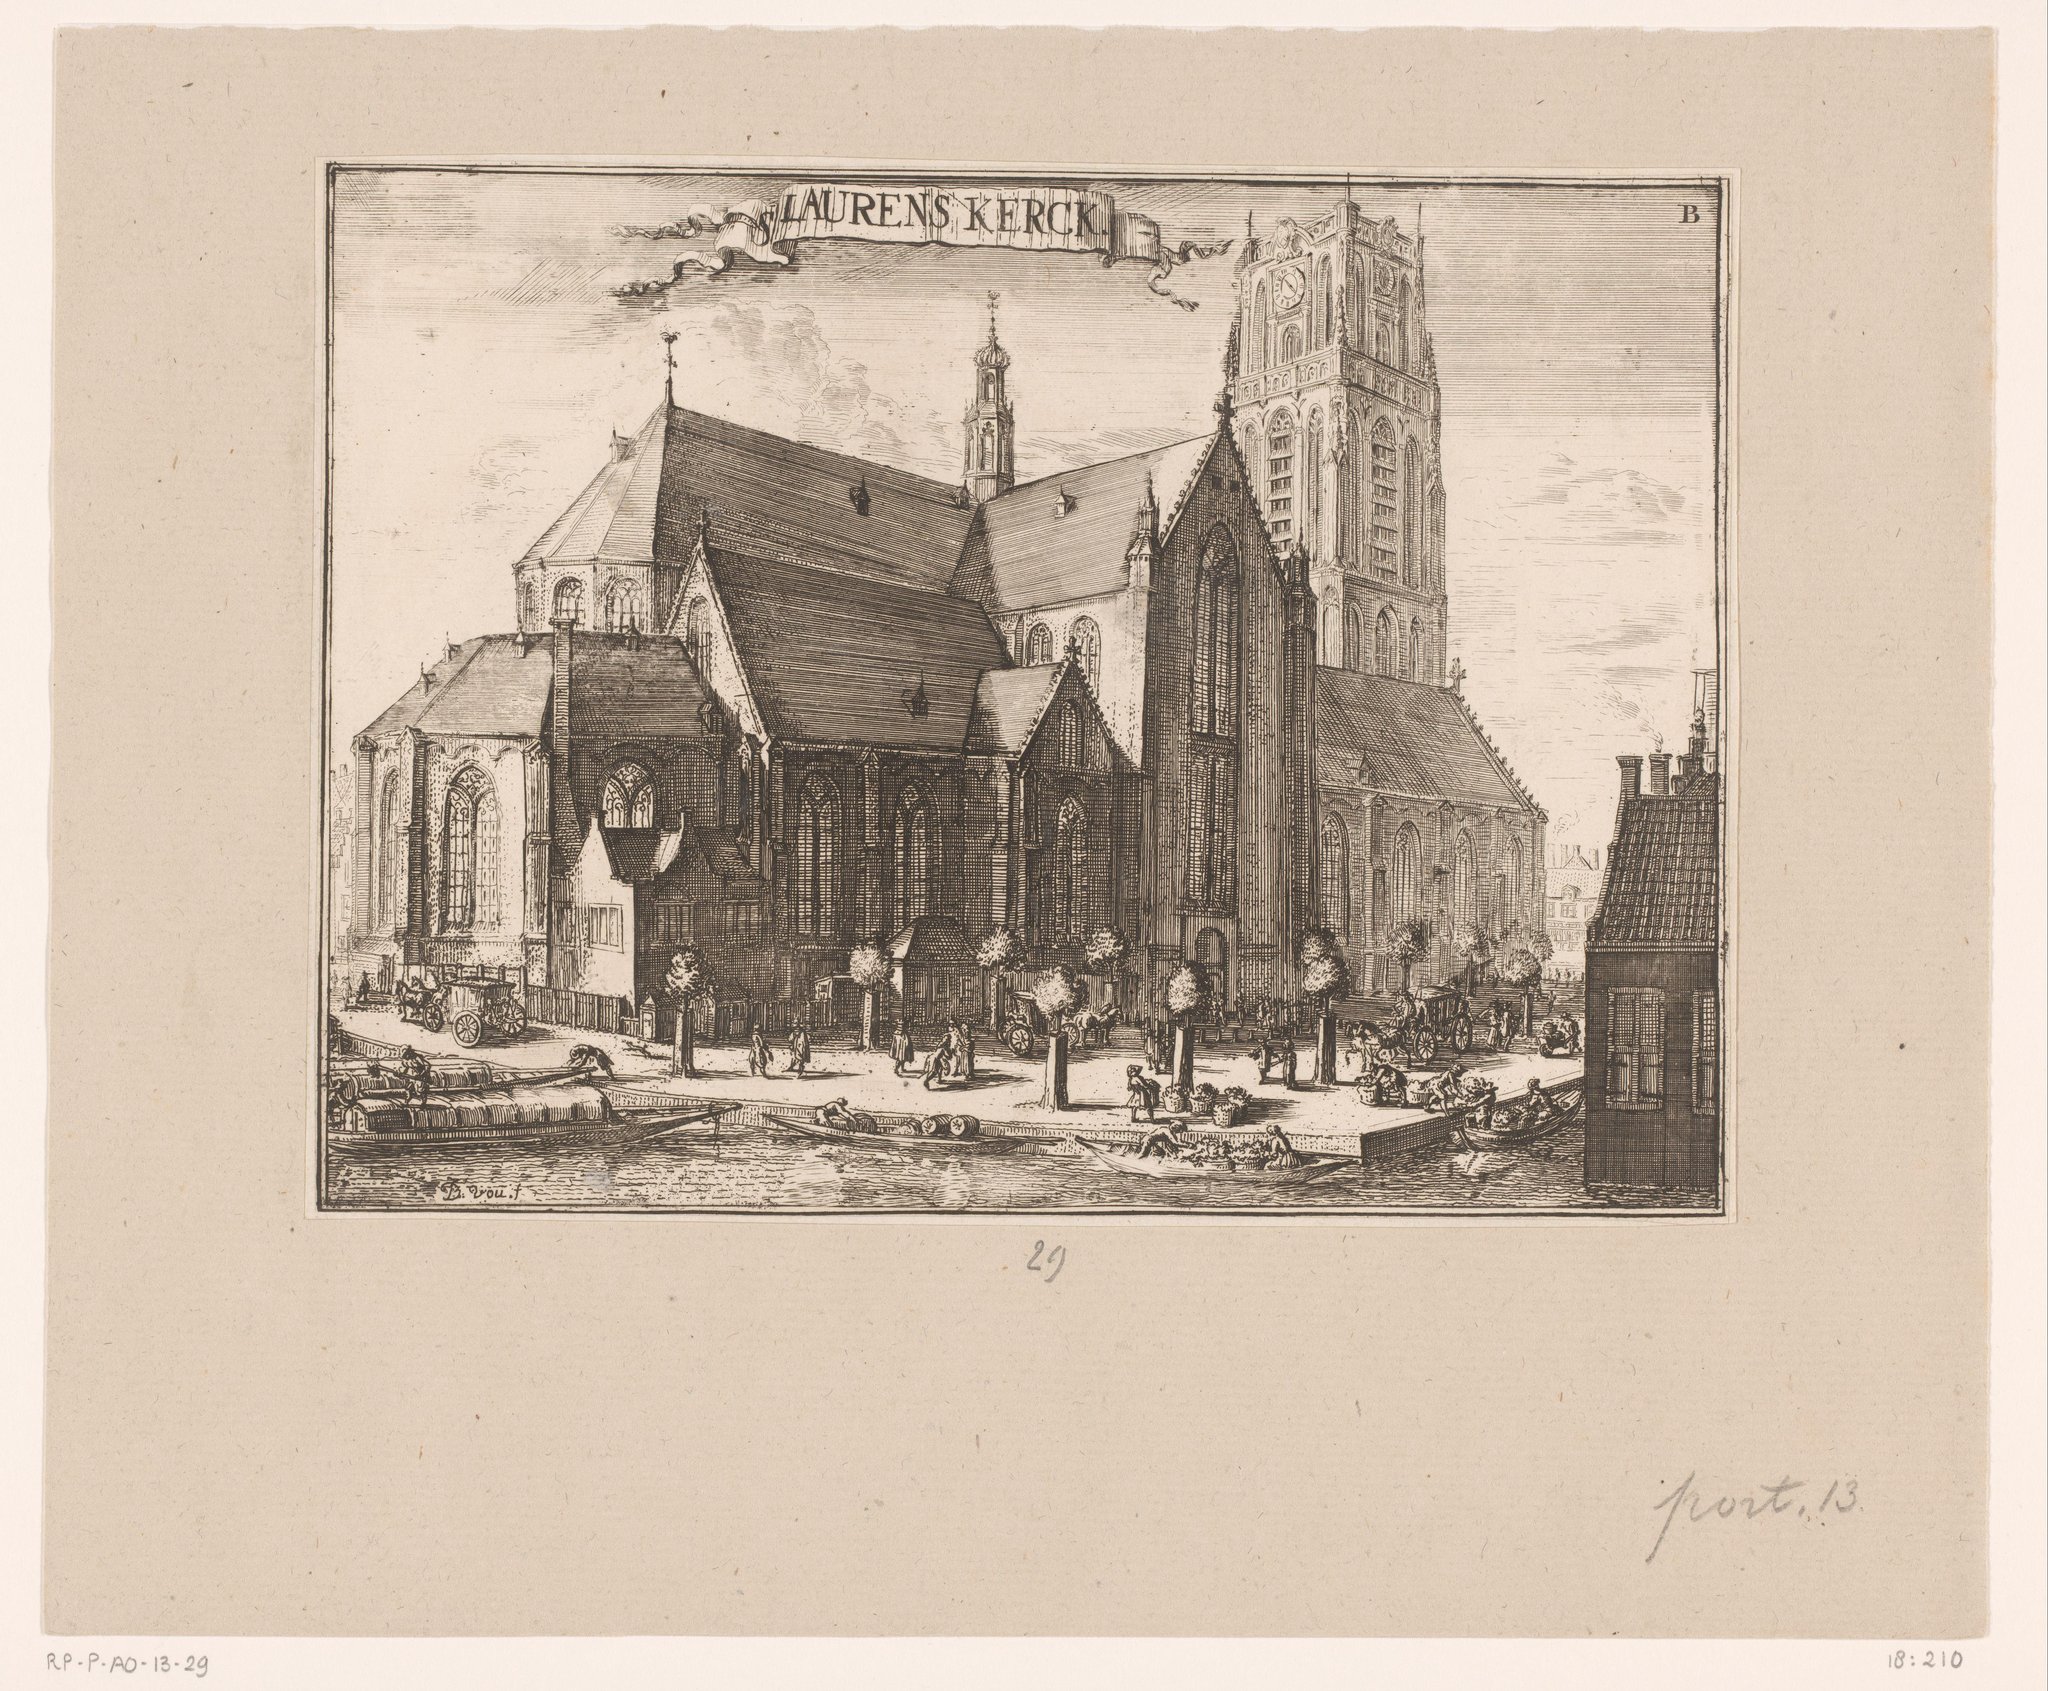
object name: print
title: Gezicht op de Grote of Sint-Laurenskerk te Rotterdam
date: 1694-1695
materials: paper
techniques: engraving, etching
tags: church (exterior), canals, waters (in city)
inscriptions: collector's mark: Lugt 195, collector's mark: Lugt 2228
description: Prent oorspronkelijk gedrukt als onderdeel van de sierrand van 'Rotterdam met al syn gebouwen net op haer maet geteekent en gesneden', een wandkaart van Rotterdam, in prent gebracht door Romeyn de Hooghe en Johannes de Vouw. De rand om de plattegrond bestond uit wapenranden (langs de bovenkant en zijkanten), twaalf stadsgezichten (A-F langs de linker zijkant en G-M langs de rechter zijkant) en een stadsprofiel (langs de onderkant). Zie documentatie voor meer informatie. Zie ook RP-P-AO-13-87.